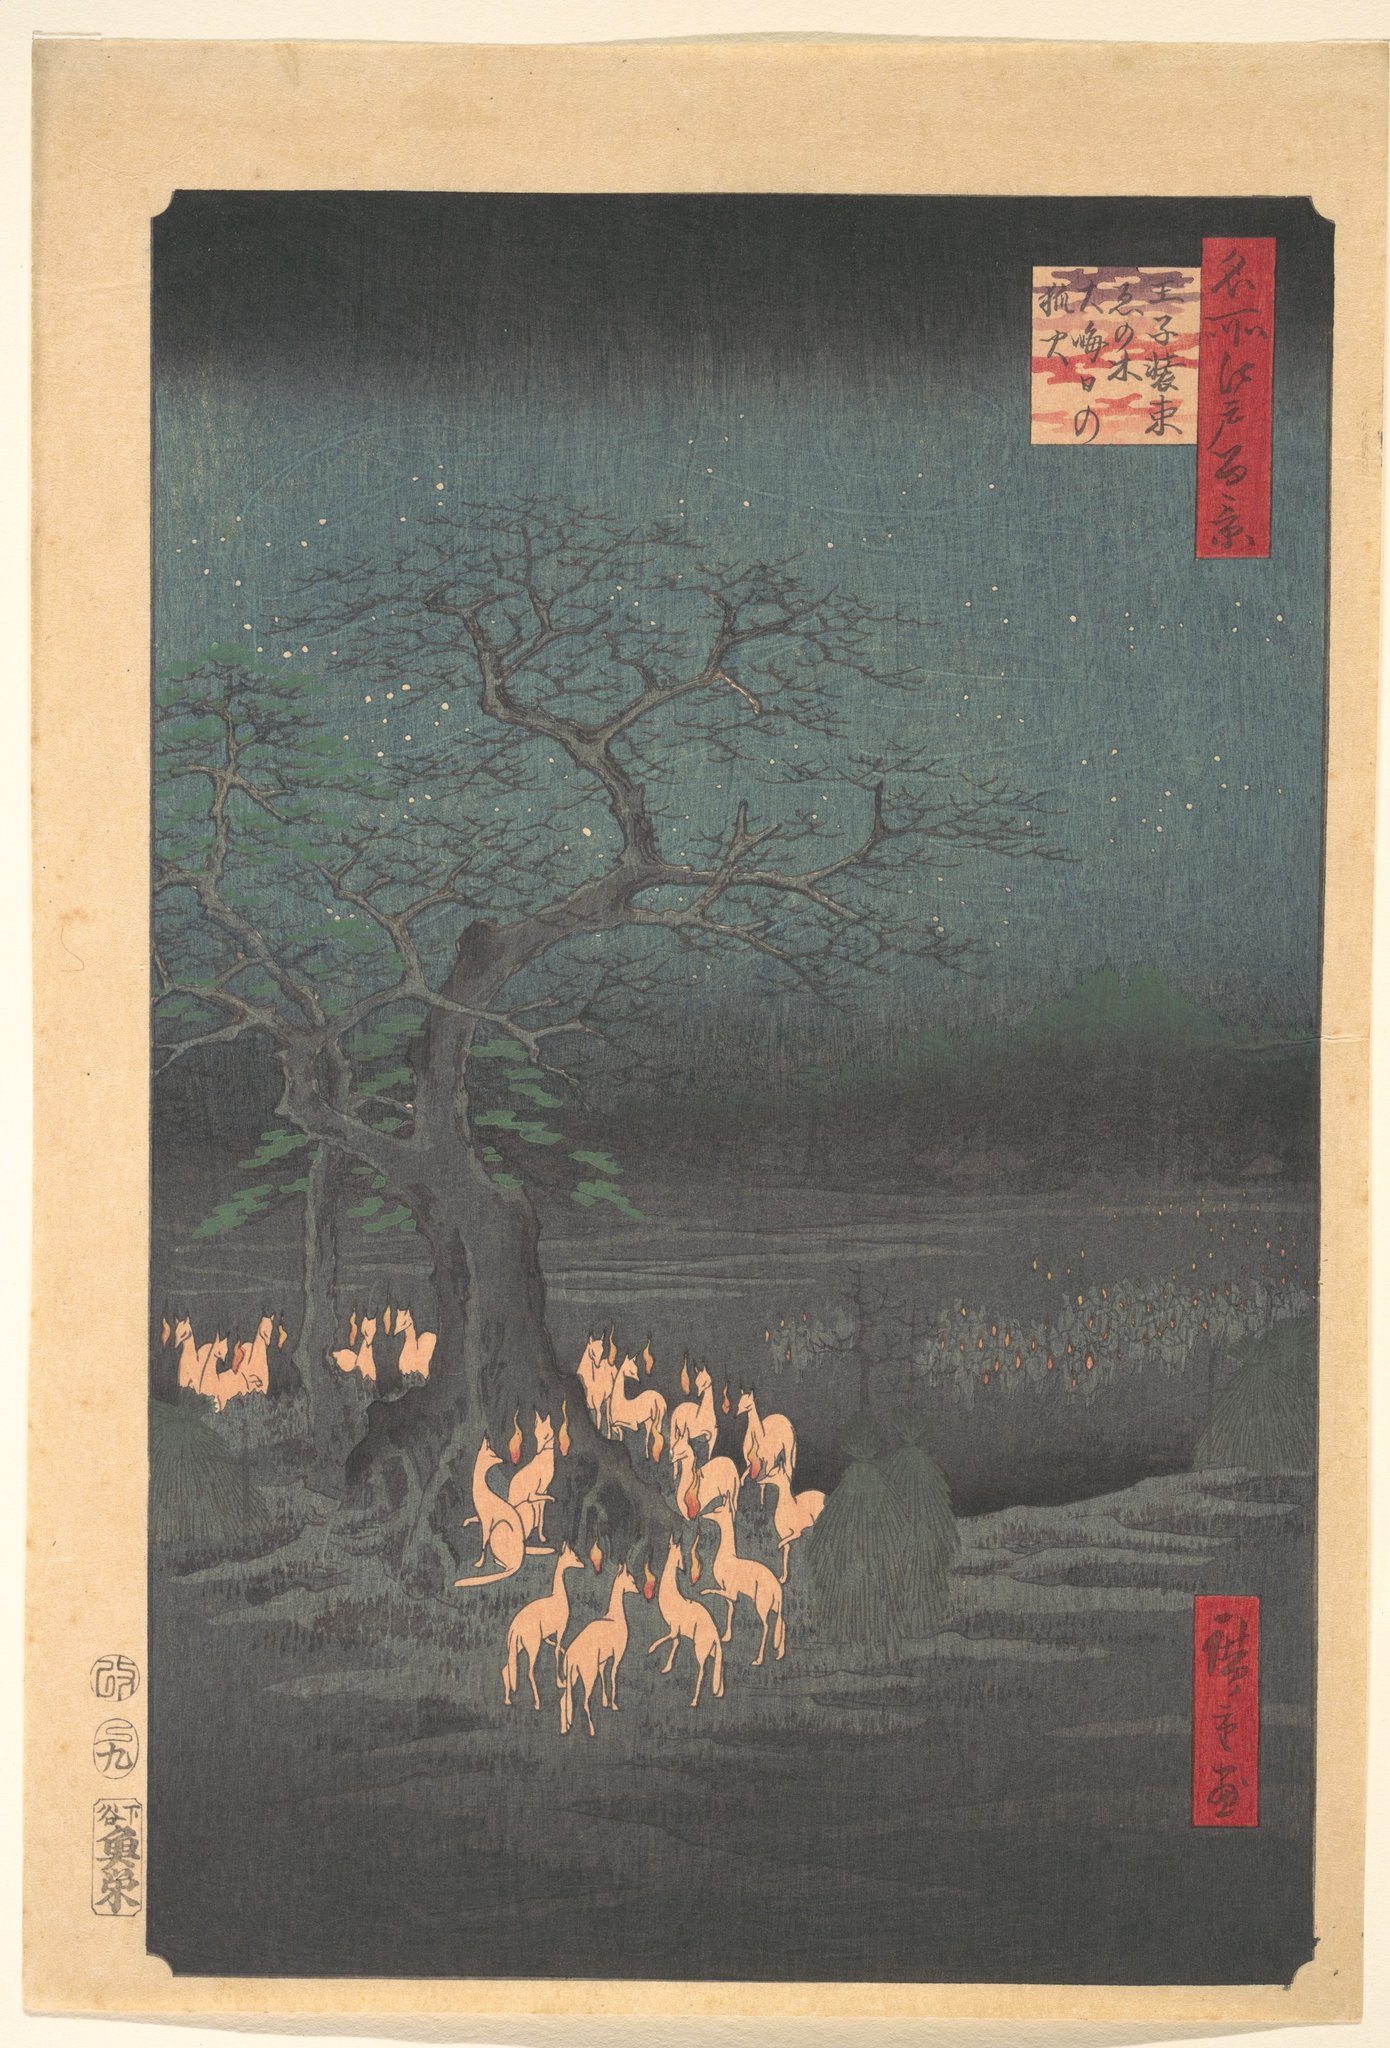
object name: print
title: Foxes Meeting at Oji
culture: japanese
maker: utagawa hiroshige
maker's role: artist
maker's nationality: japanese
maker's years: 1797-1858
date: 1857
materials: ink, paper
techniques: woodblock print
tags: foxes,trees,night